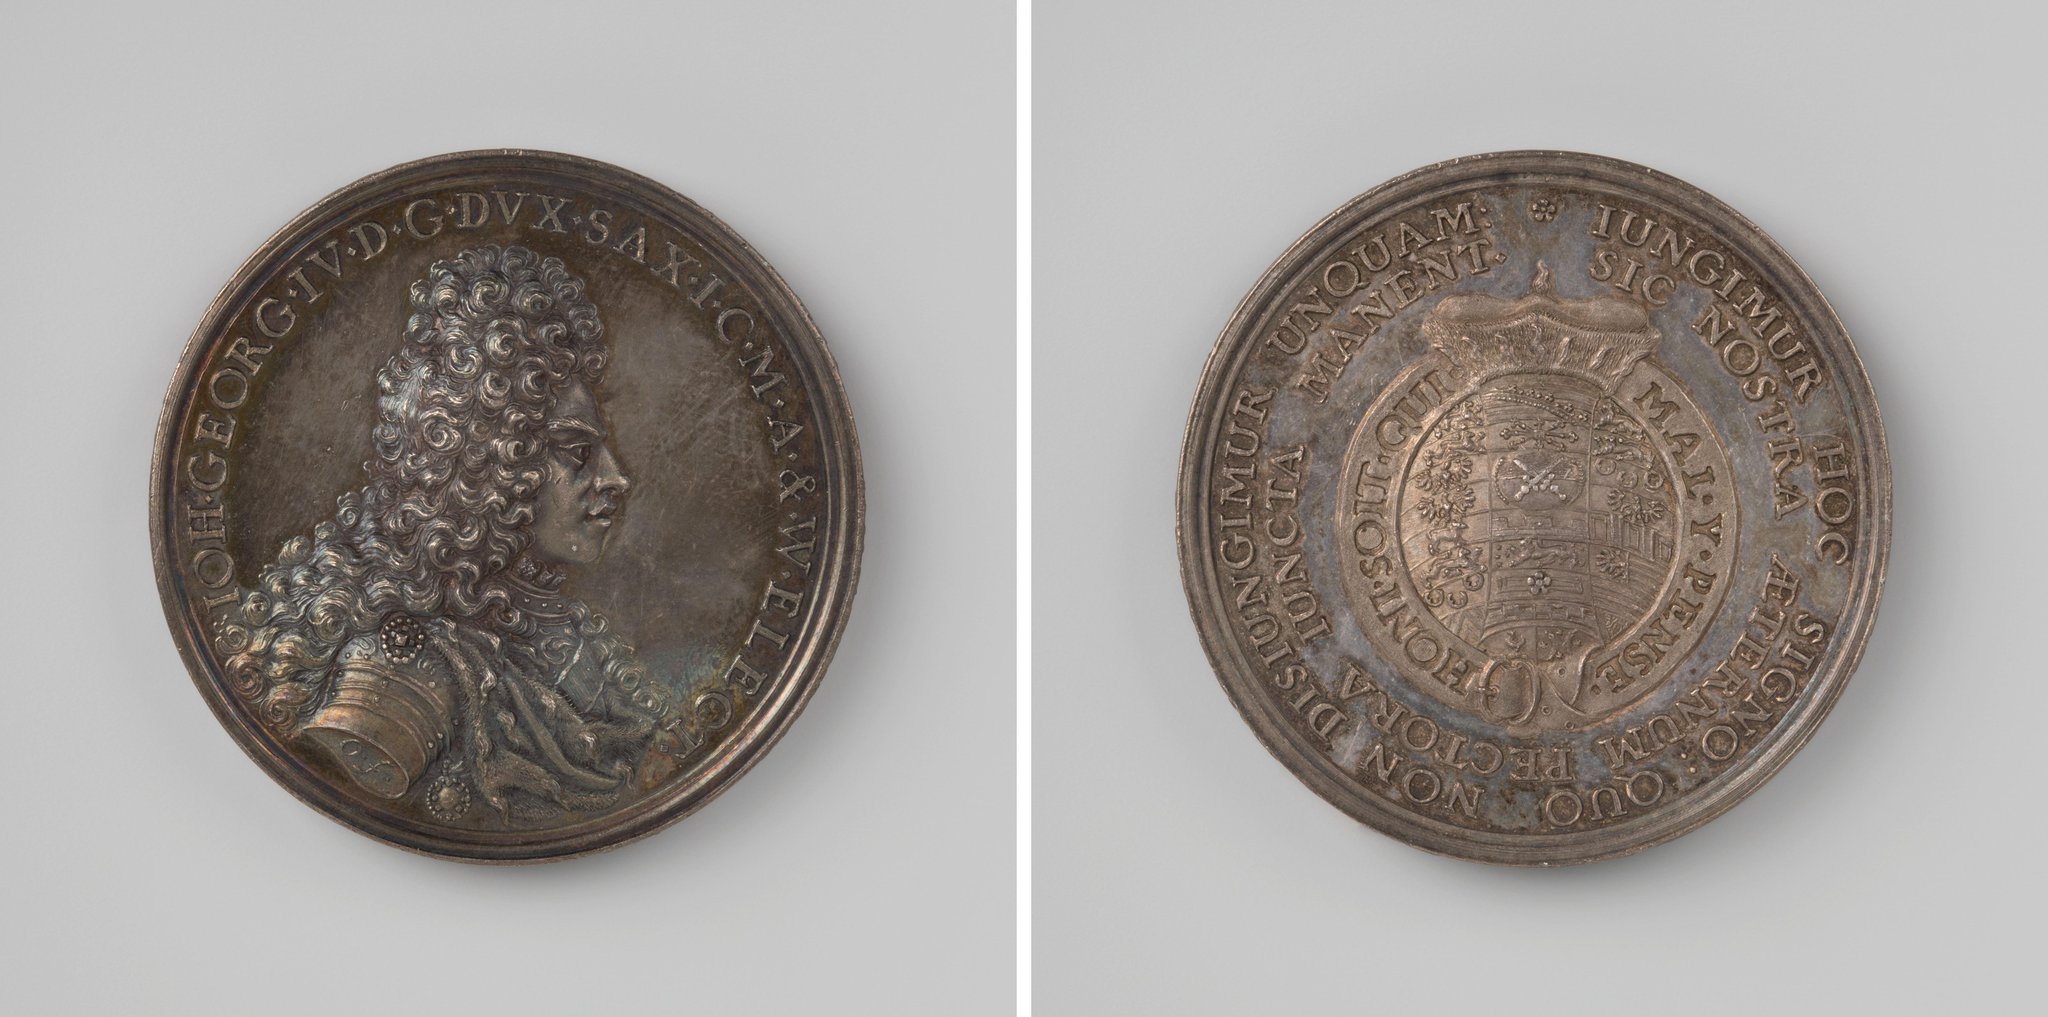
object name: history medal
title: Johan Georg IV, keurvorst van Saksen door Willem III benoemd tot ridder van de Kouseband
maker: martin heinrich omeis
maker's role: print maker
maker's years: 1650-1703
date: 1693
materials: silver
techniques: striking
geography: dresden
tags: orde van de kouseband, keurvorst, keurvorst van saksen johan georg iv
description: Zilveren penning. Voorzijde: borststuk man binnen omschrift. Keerzijde: wapenschild gekroond met keurvorstelijke muts en omgeven door kouseband binnen dubbel omschrift; randschrift